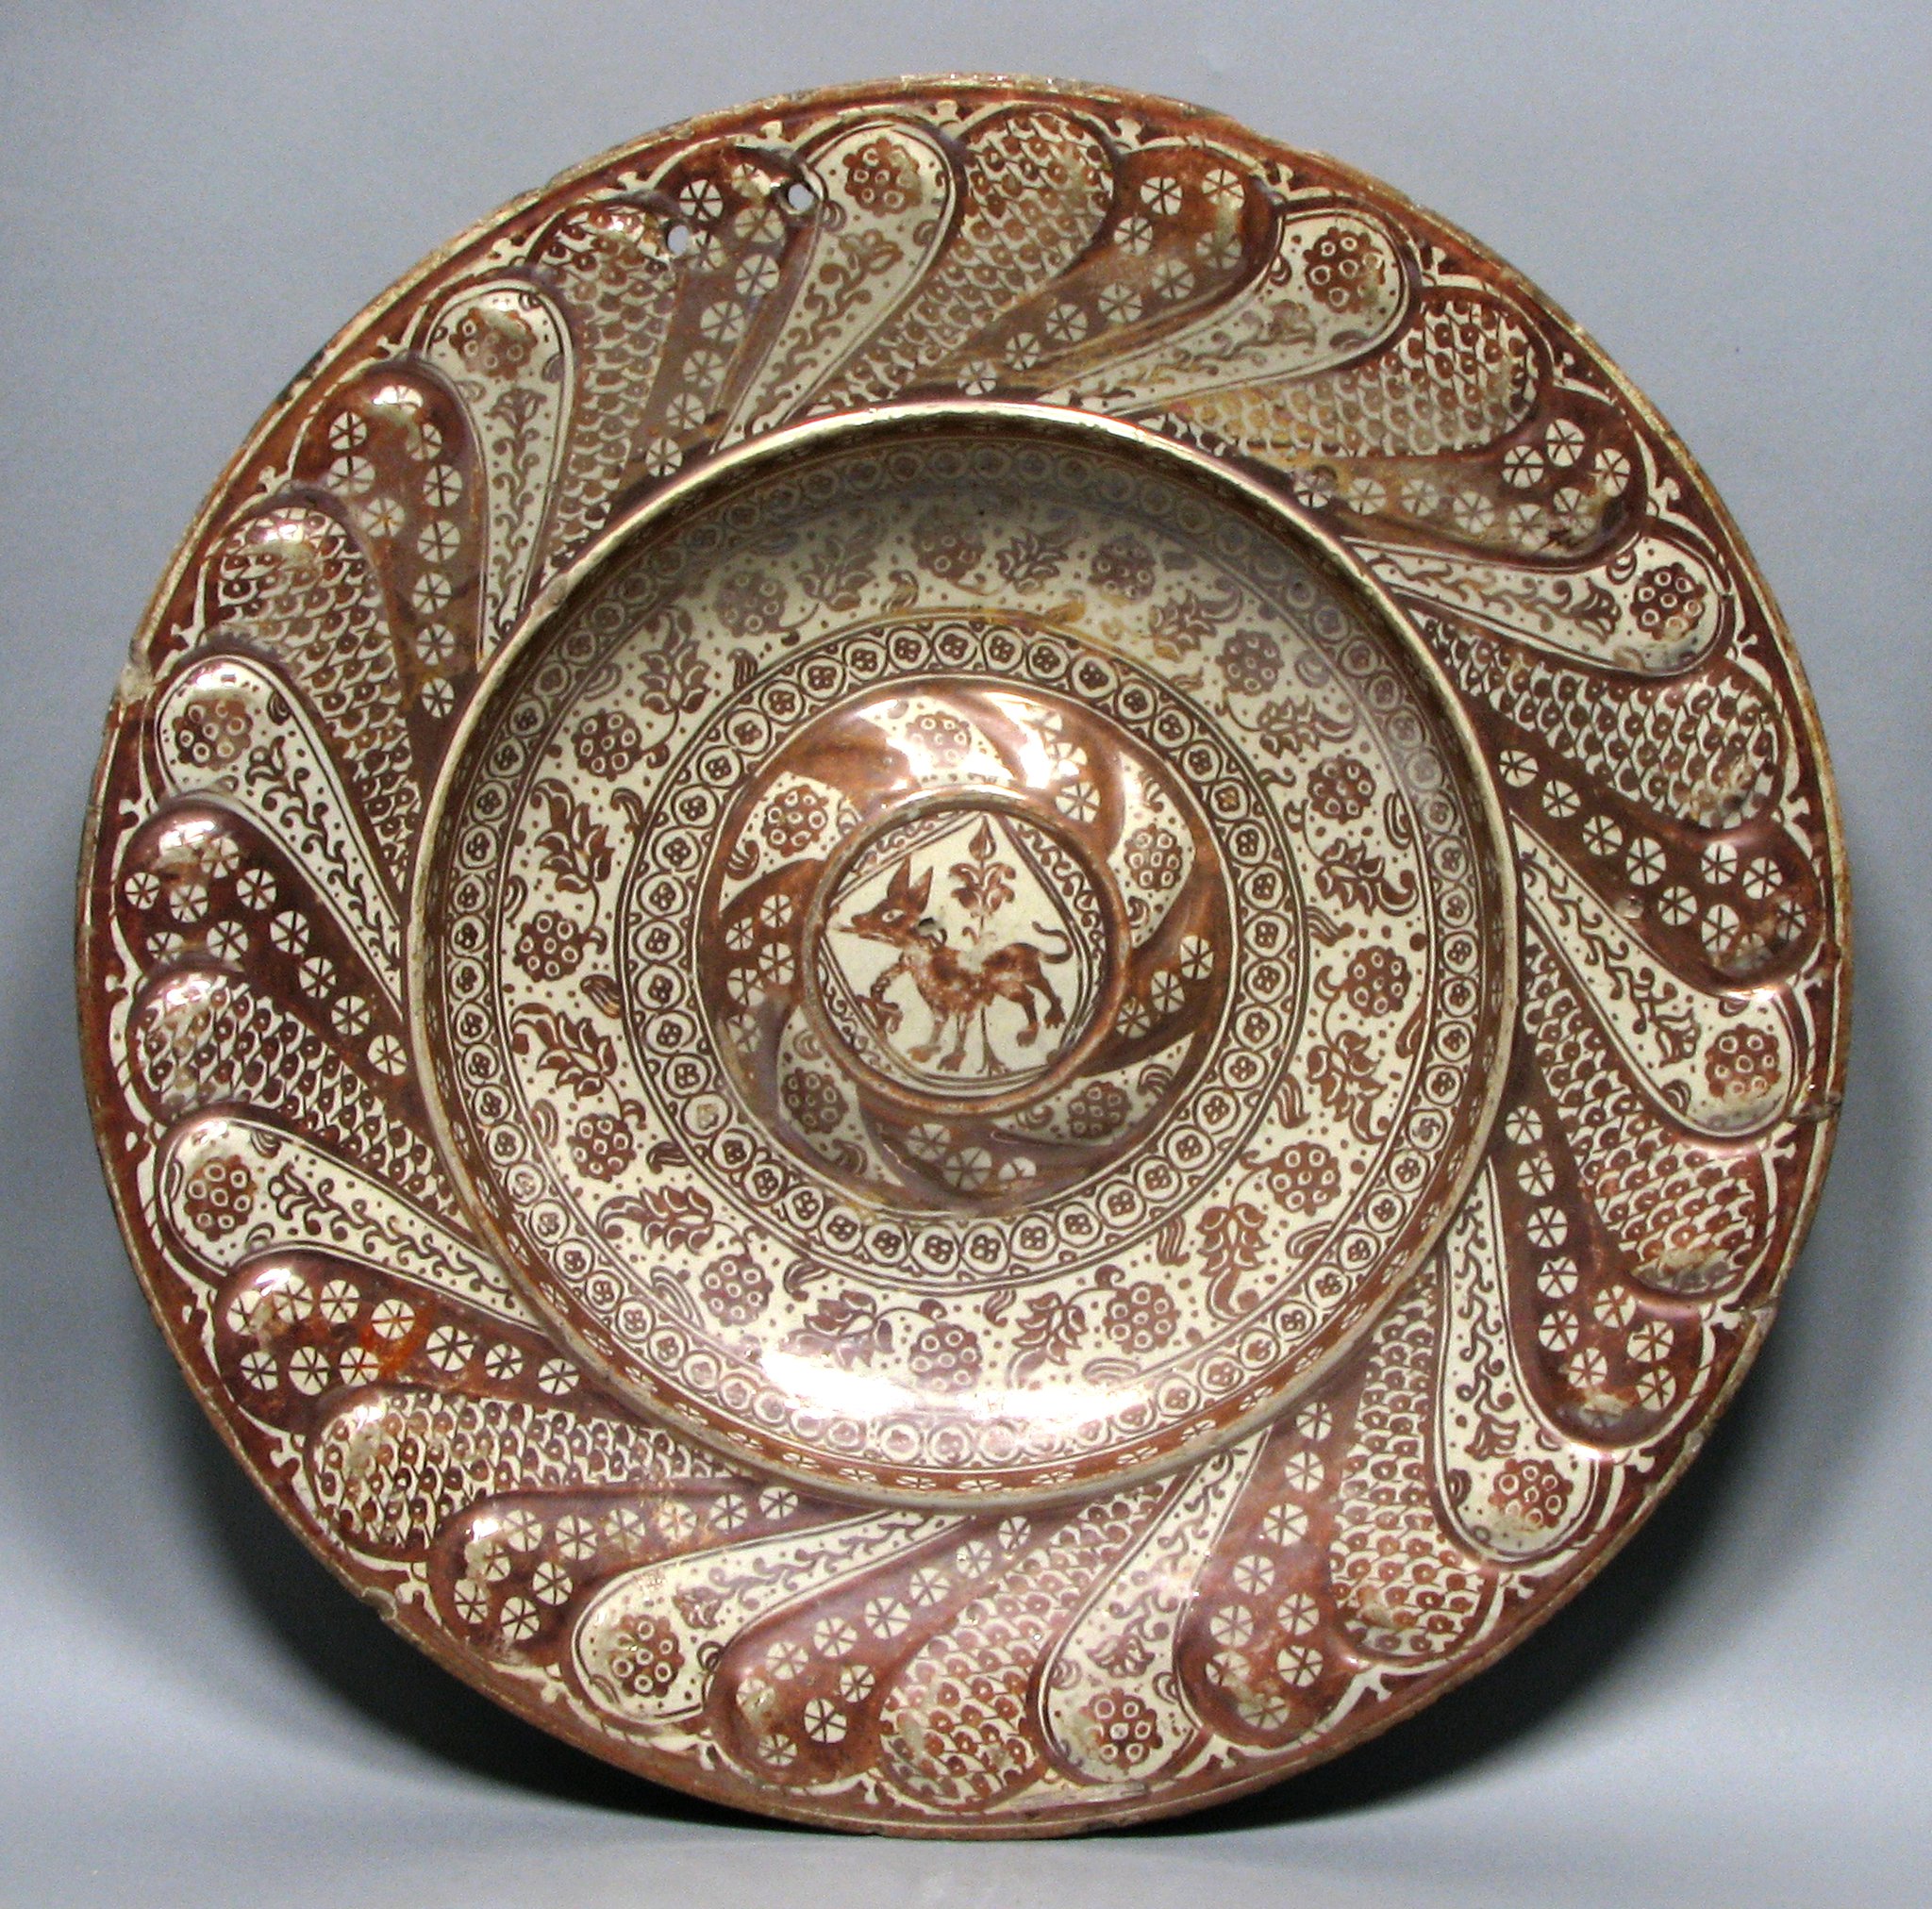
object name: dish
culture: spanish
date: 1467-1500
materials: earthenware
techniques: glazing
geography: spain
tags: animals